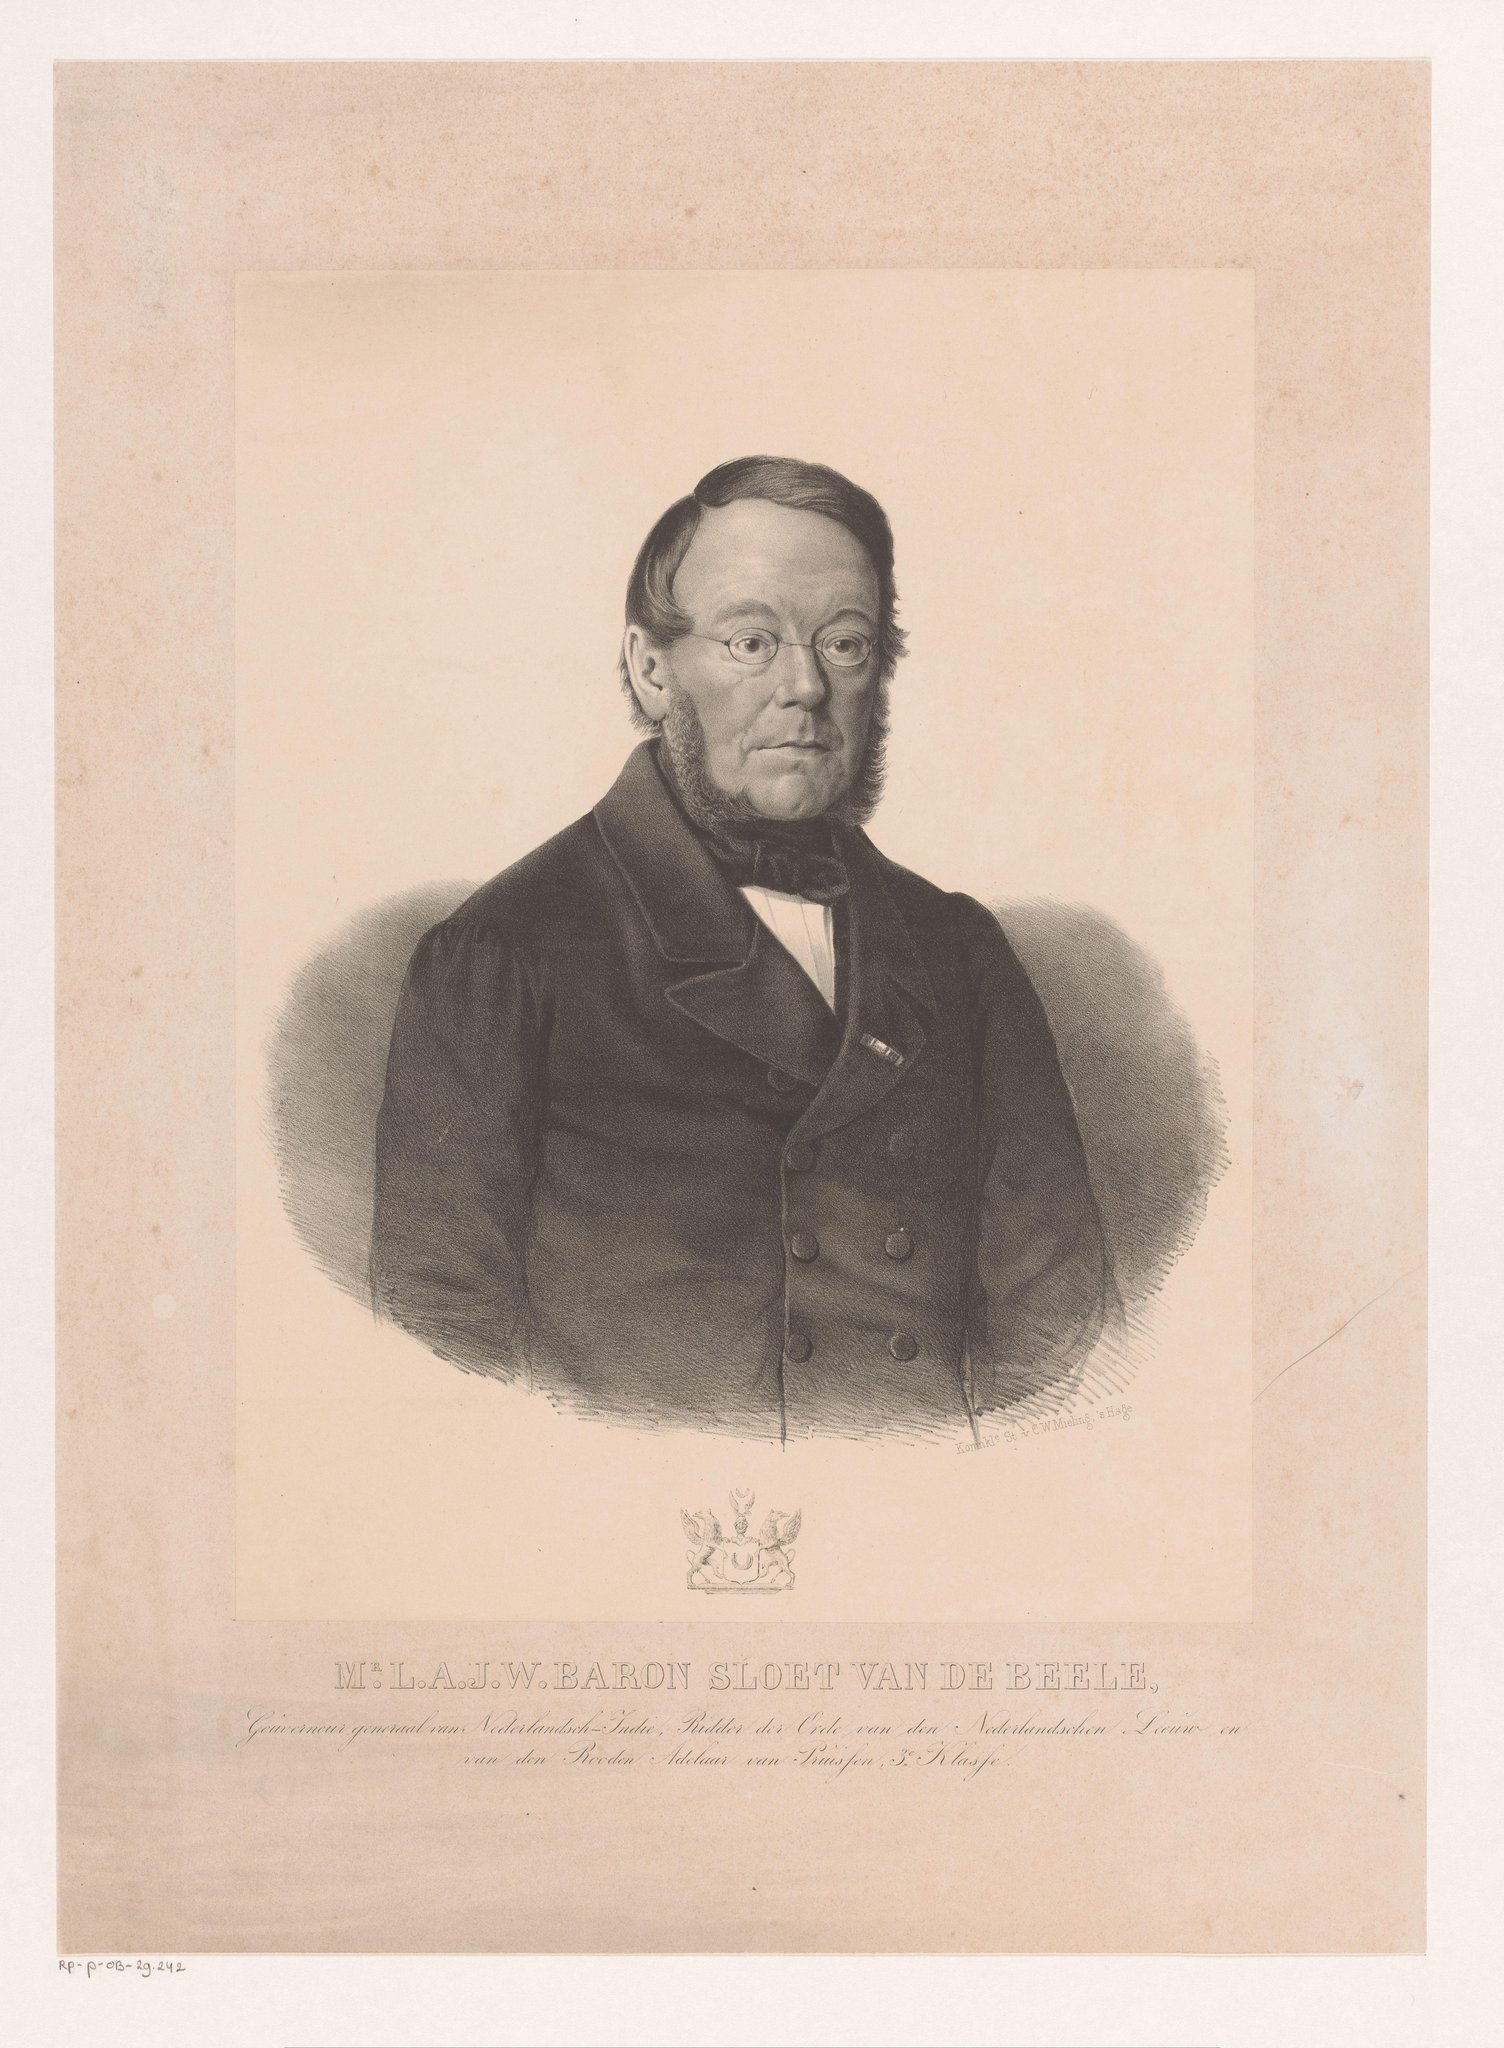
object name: print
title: Portret Ludolph Anne Jan Wilt Sloet van de Beele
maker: Anonymous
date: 1847-1865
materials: paper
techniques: lithograph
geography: the hague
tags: arnhem, politician, historical persons (+ (full) bust portrait), armorial bearing, heraldry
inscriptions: collector's mark: Lugt 2228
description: Onder het portret het wapens van de familie Sloet.